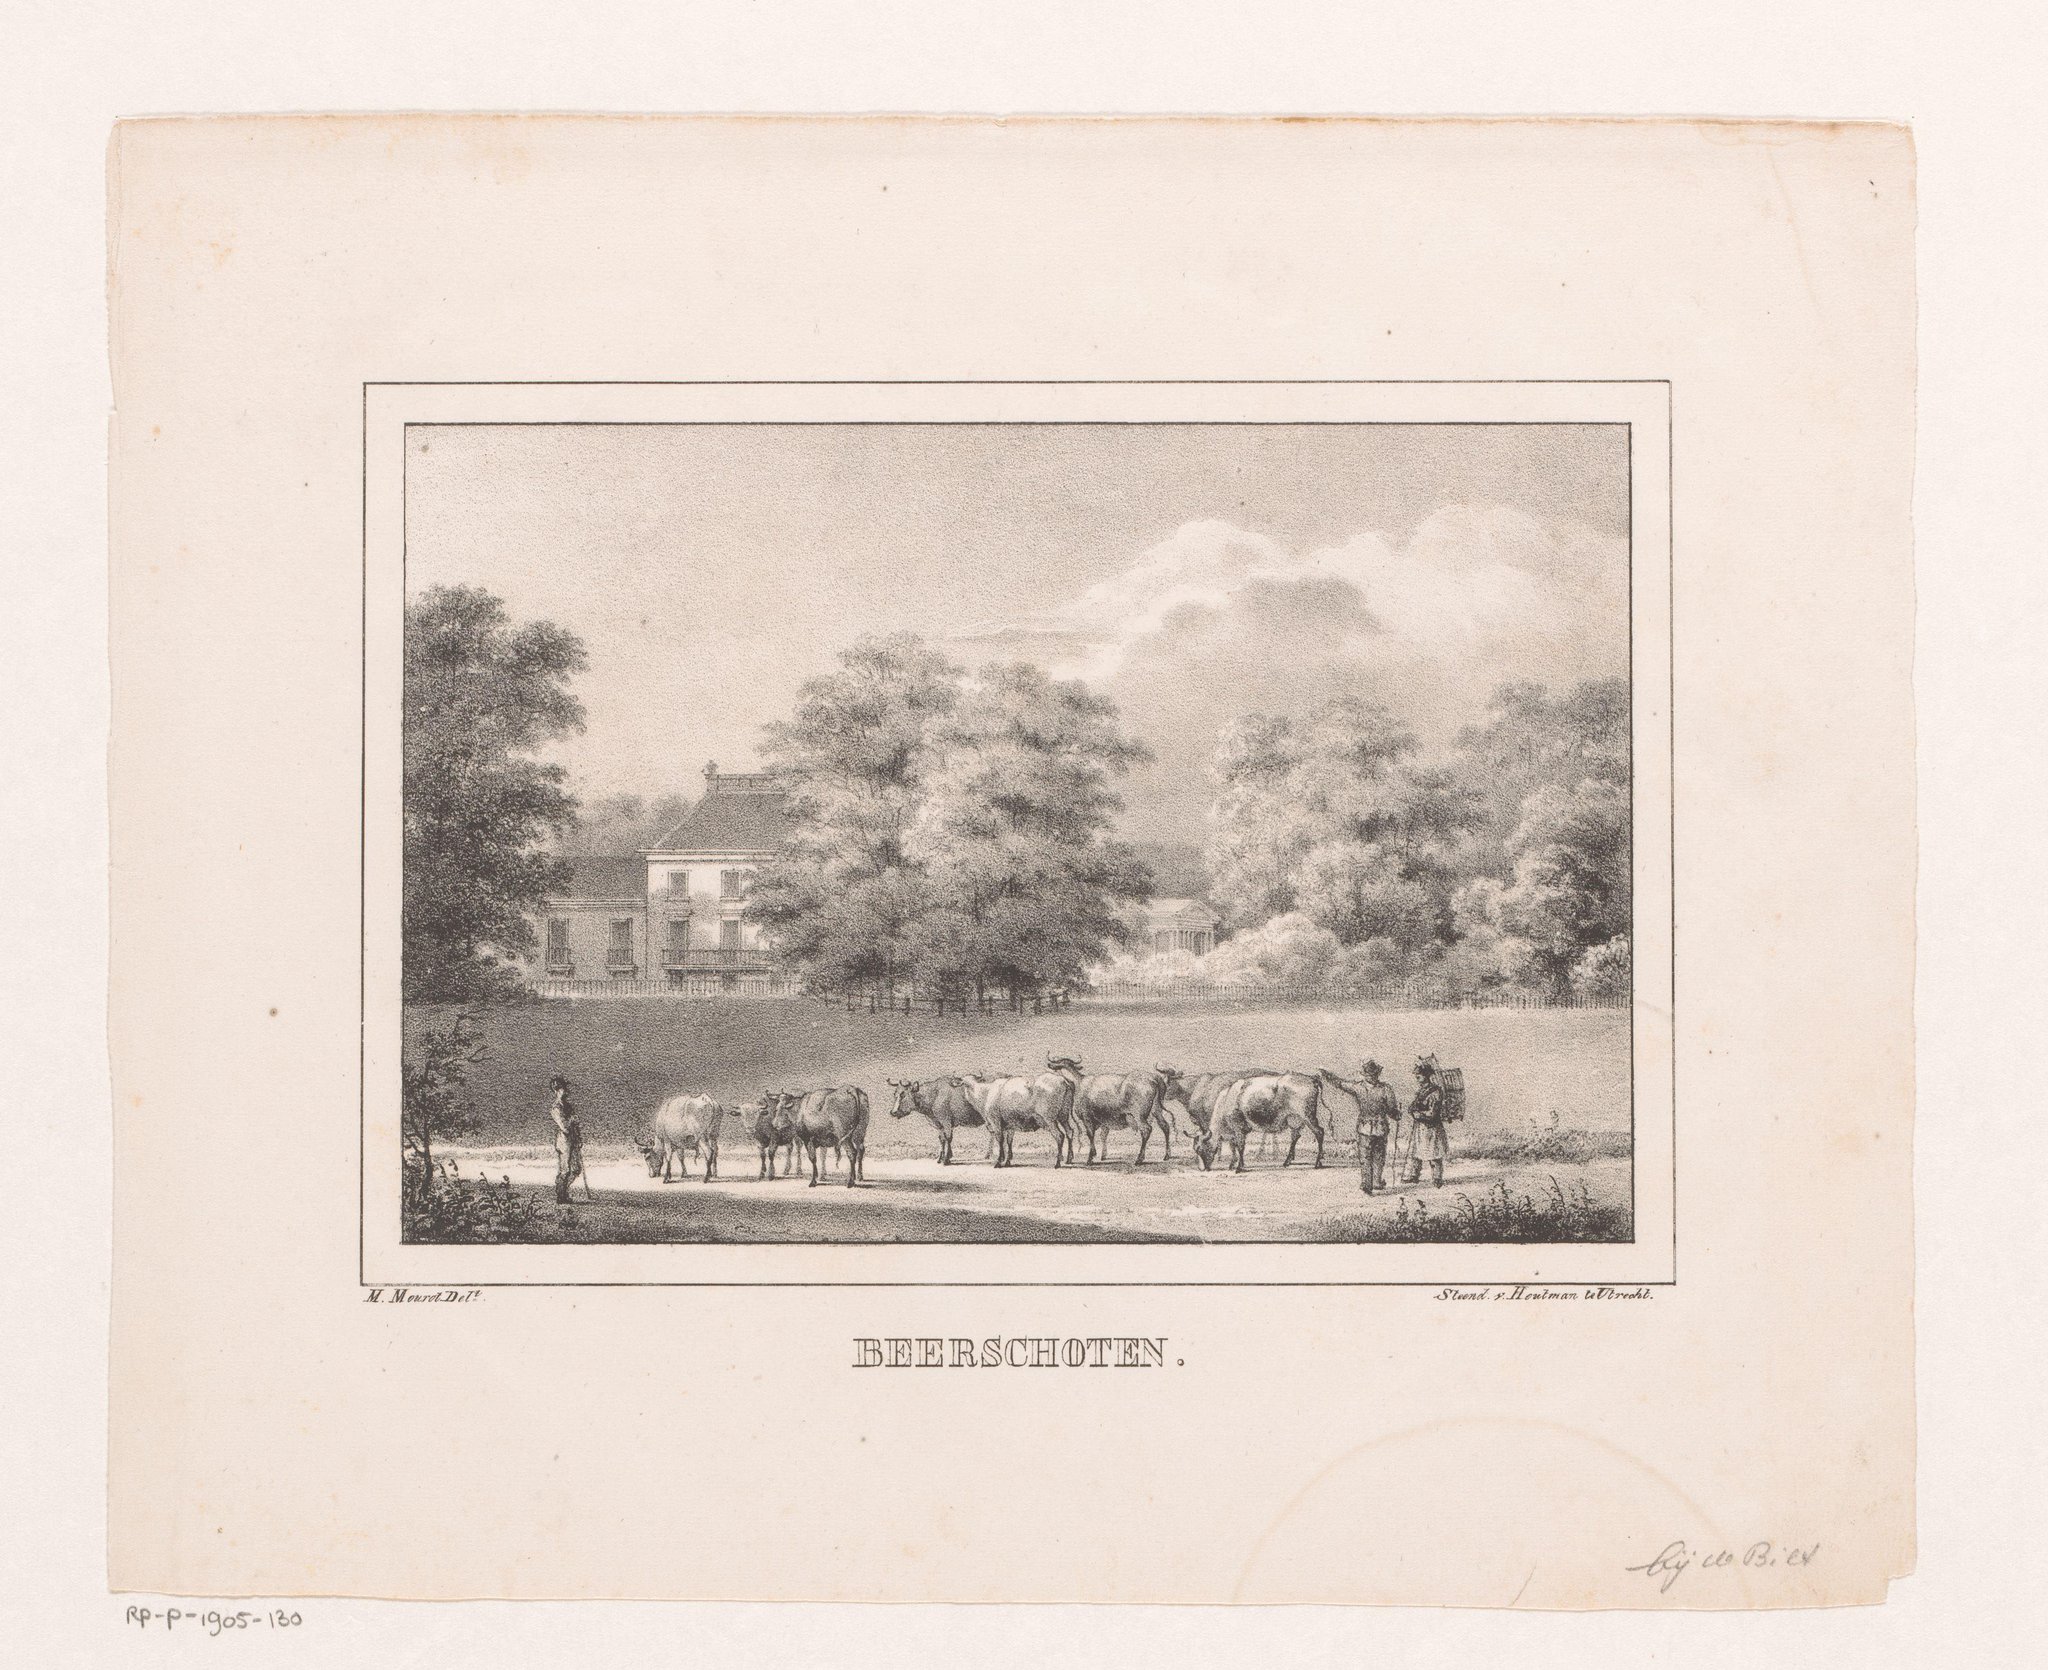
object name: print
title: Beerschoten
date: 1829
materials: paper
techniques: lithograph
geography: utrecht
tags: cow, summer, 'aestas'; 'estate' (ripa), herd, flock, country-house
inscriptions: collector's mark: Lugt 2228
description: Uitgegeven in: Gezigten van buitenplaatsen en gebouwen gelegen tusschen de Stad Utrecht en de Grebbe. Utrecht, I. P. Houtman: 1829.